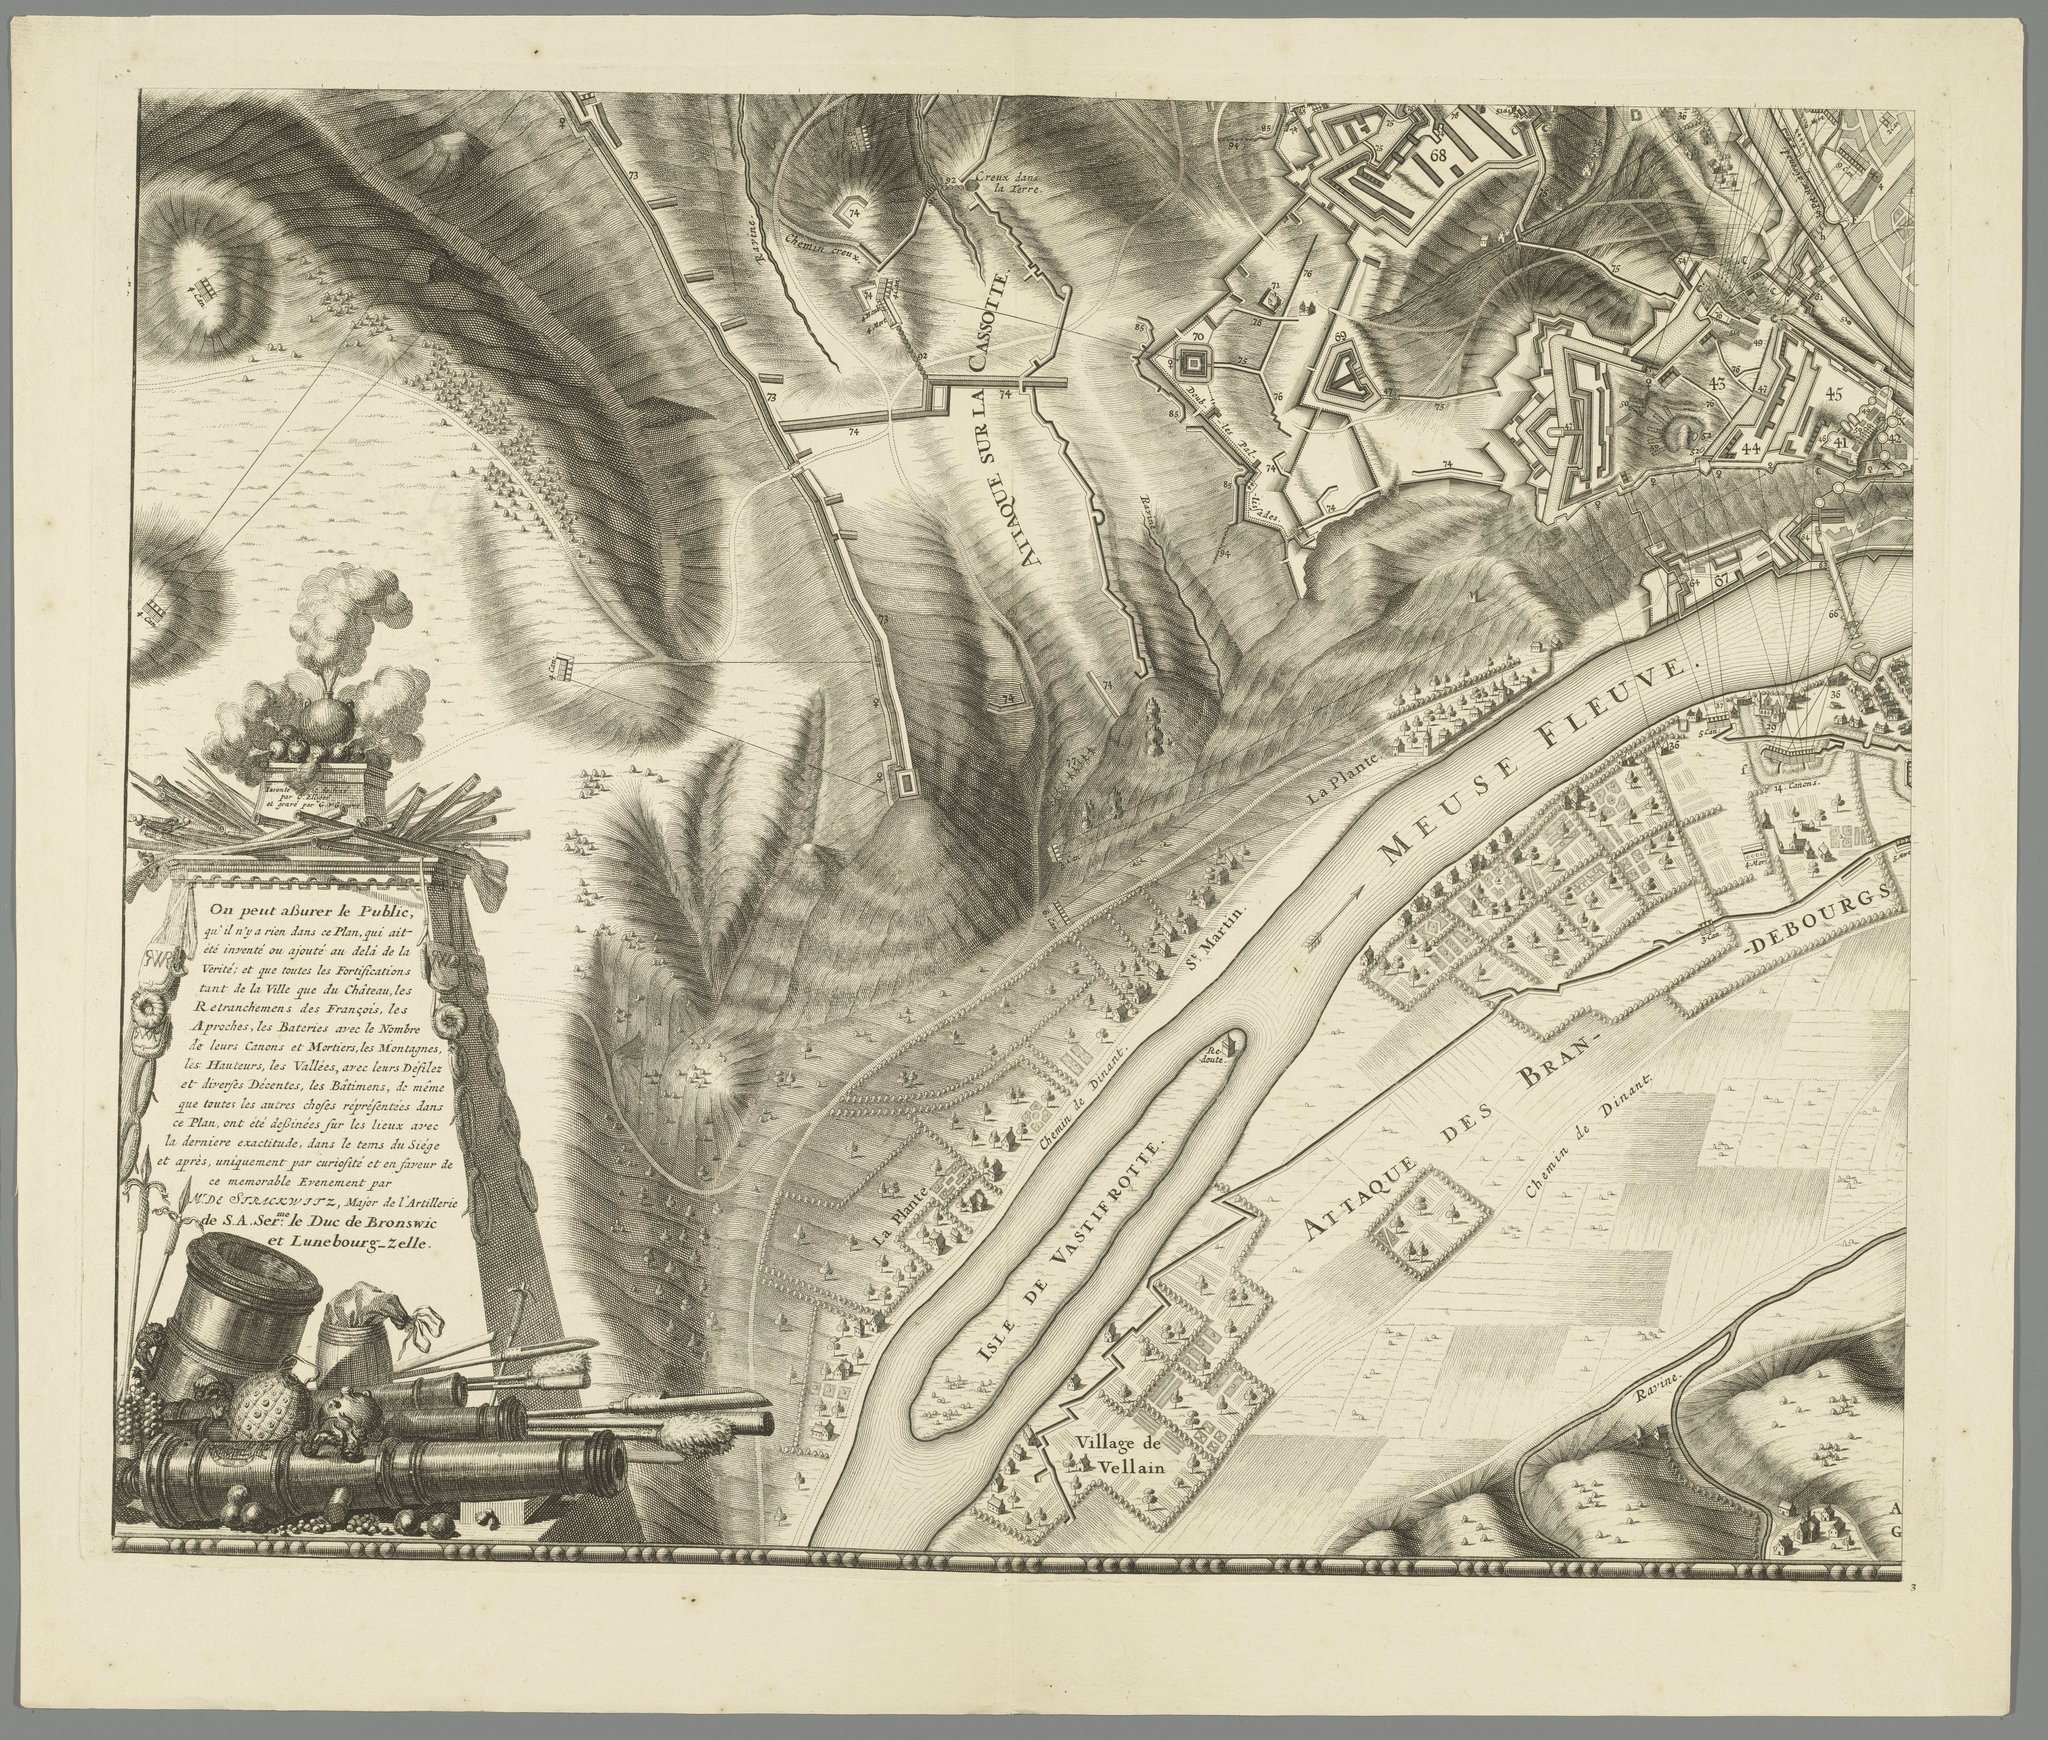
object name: print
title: Grote kaart van het beleg van Namen (blad nr. 3), 1695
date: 1695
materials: paper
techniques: etching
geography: amsterdam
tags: the hague, william iii (prince of orange and king of england, scotland, and ireland), siege, position war, maps of cities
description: Grote ongemonteerde kaart van het beleg van Namen door de geallieerden onder koning Willem III tijdens de maanden juli-september 1695. De kaart is opgebouwd uit vier losse genummerde voorstellingen en twee bladen met het onderschrift. Dit blad (nr. 3) is het deel linksonder. Onderaan een monument en trofee opgebouwd uit kanonnen en andere wapens.